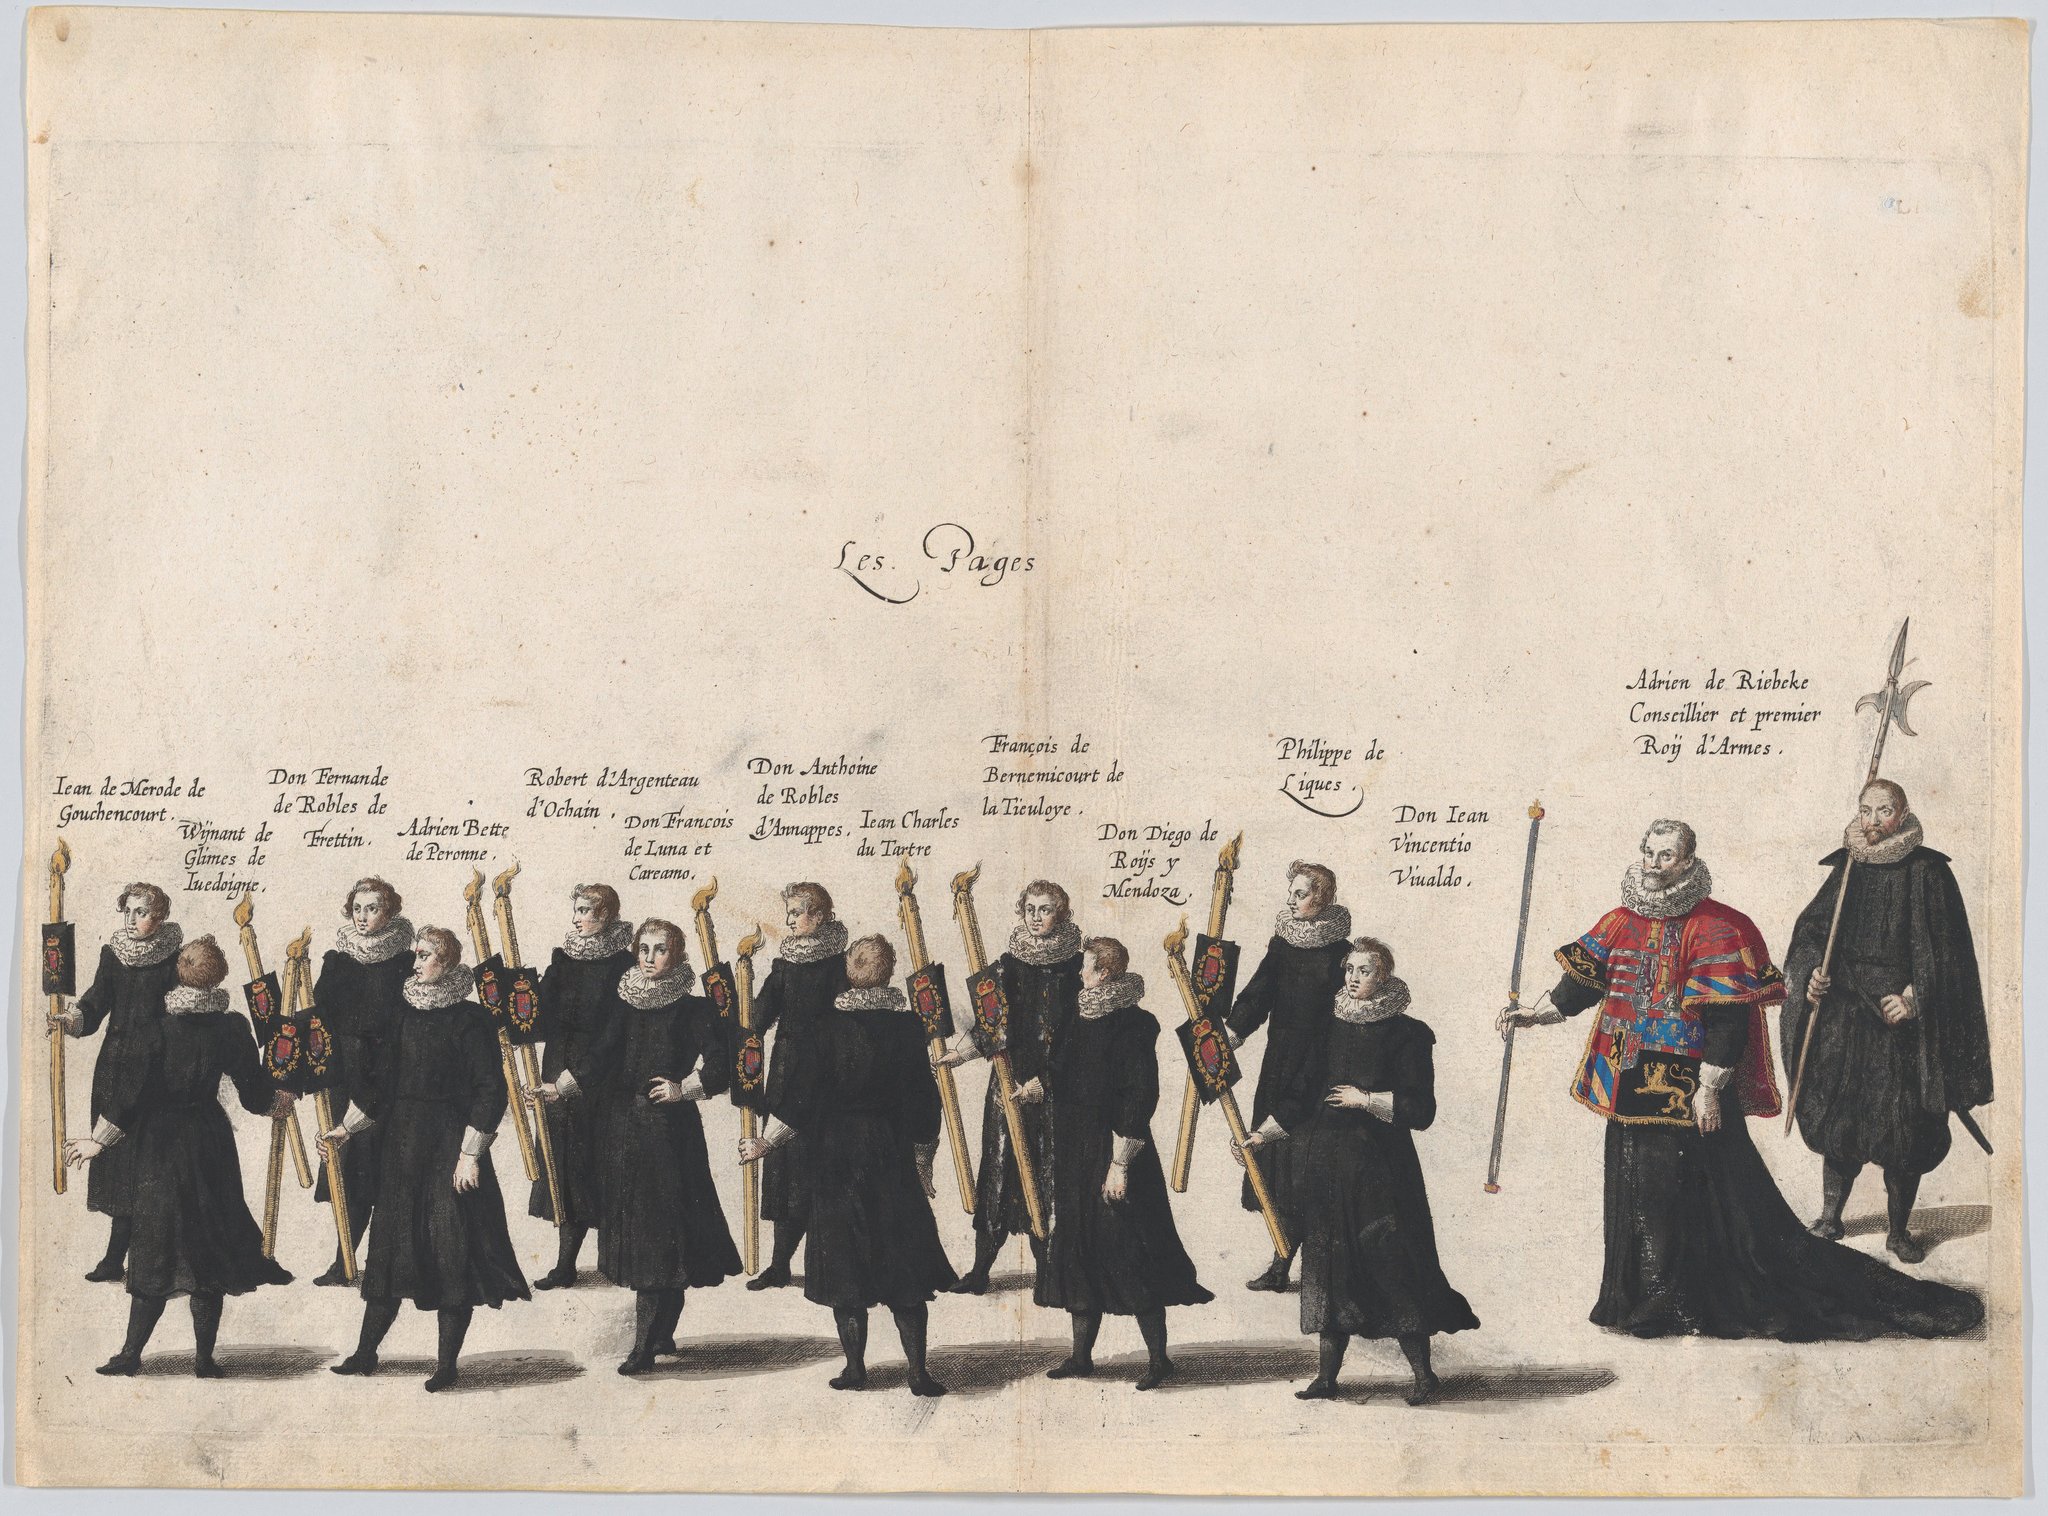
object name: print, fete, ornament architecture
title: Plate 54: The pages marching in the funeral procession of Archduke Albert of Austria; from 'Pompa Funebris ... Alberti Pii'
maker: cornelis galle (i)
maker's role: artist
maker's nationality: netherlandish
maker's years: 1576-1650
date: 1623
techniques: etching, hand coloring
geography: brussels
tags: men,funerals,processions